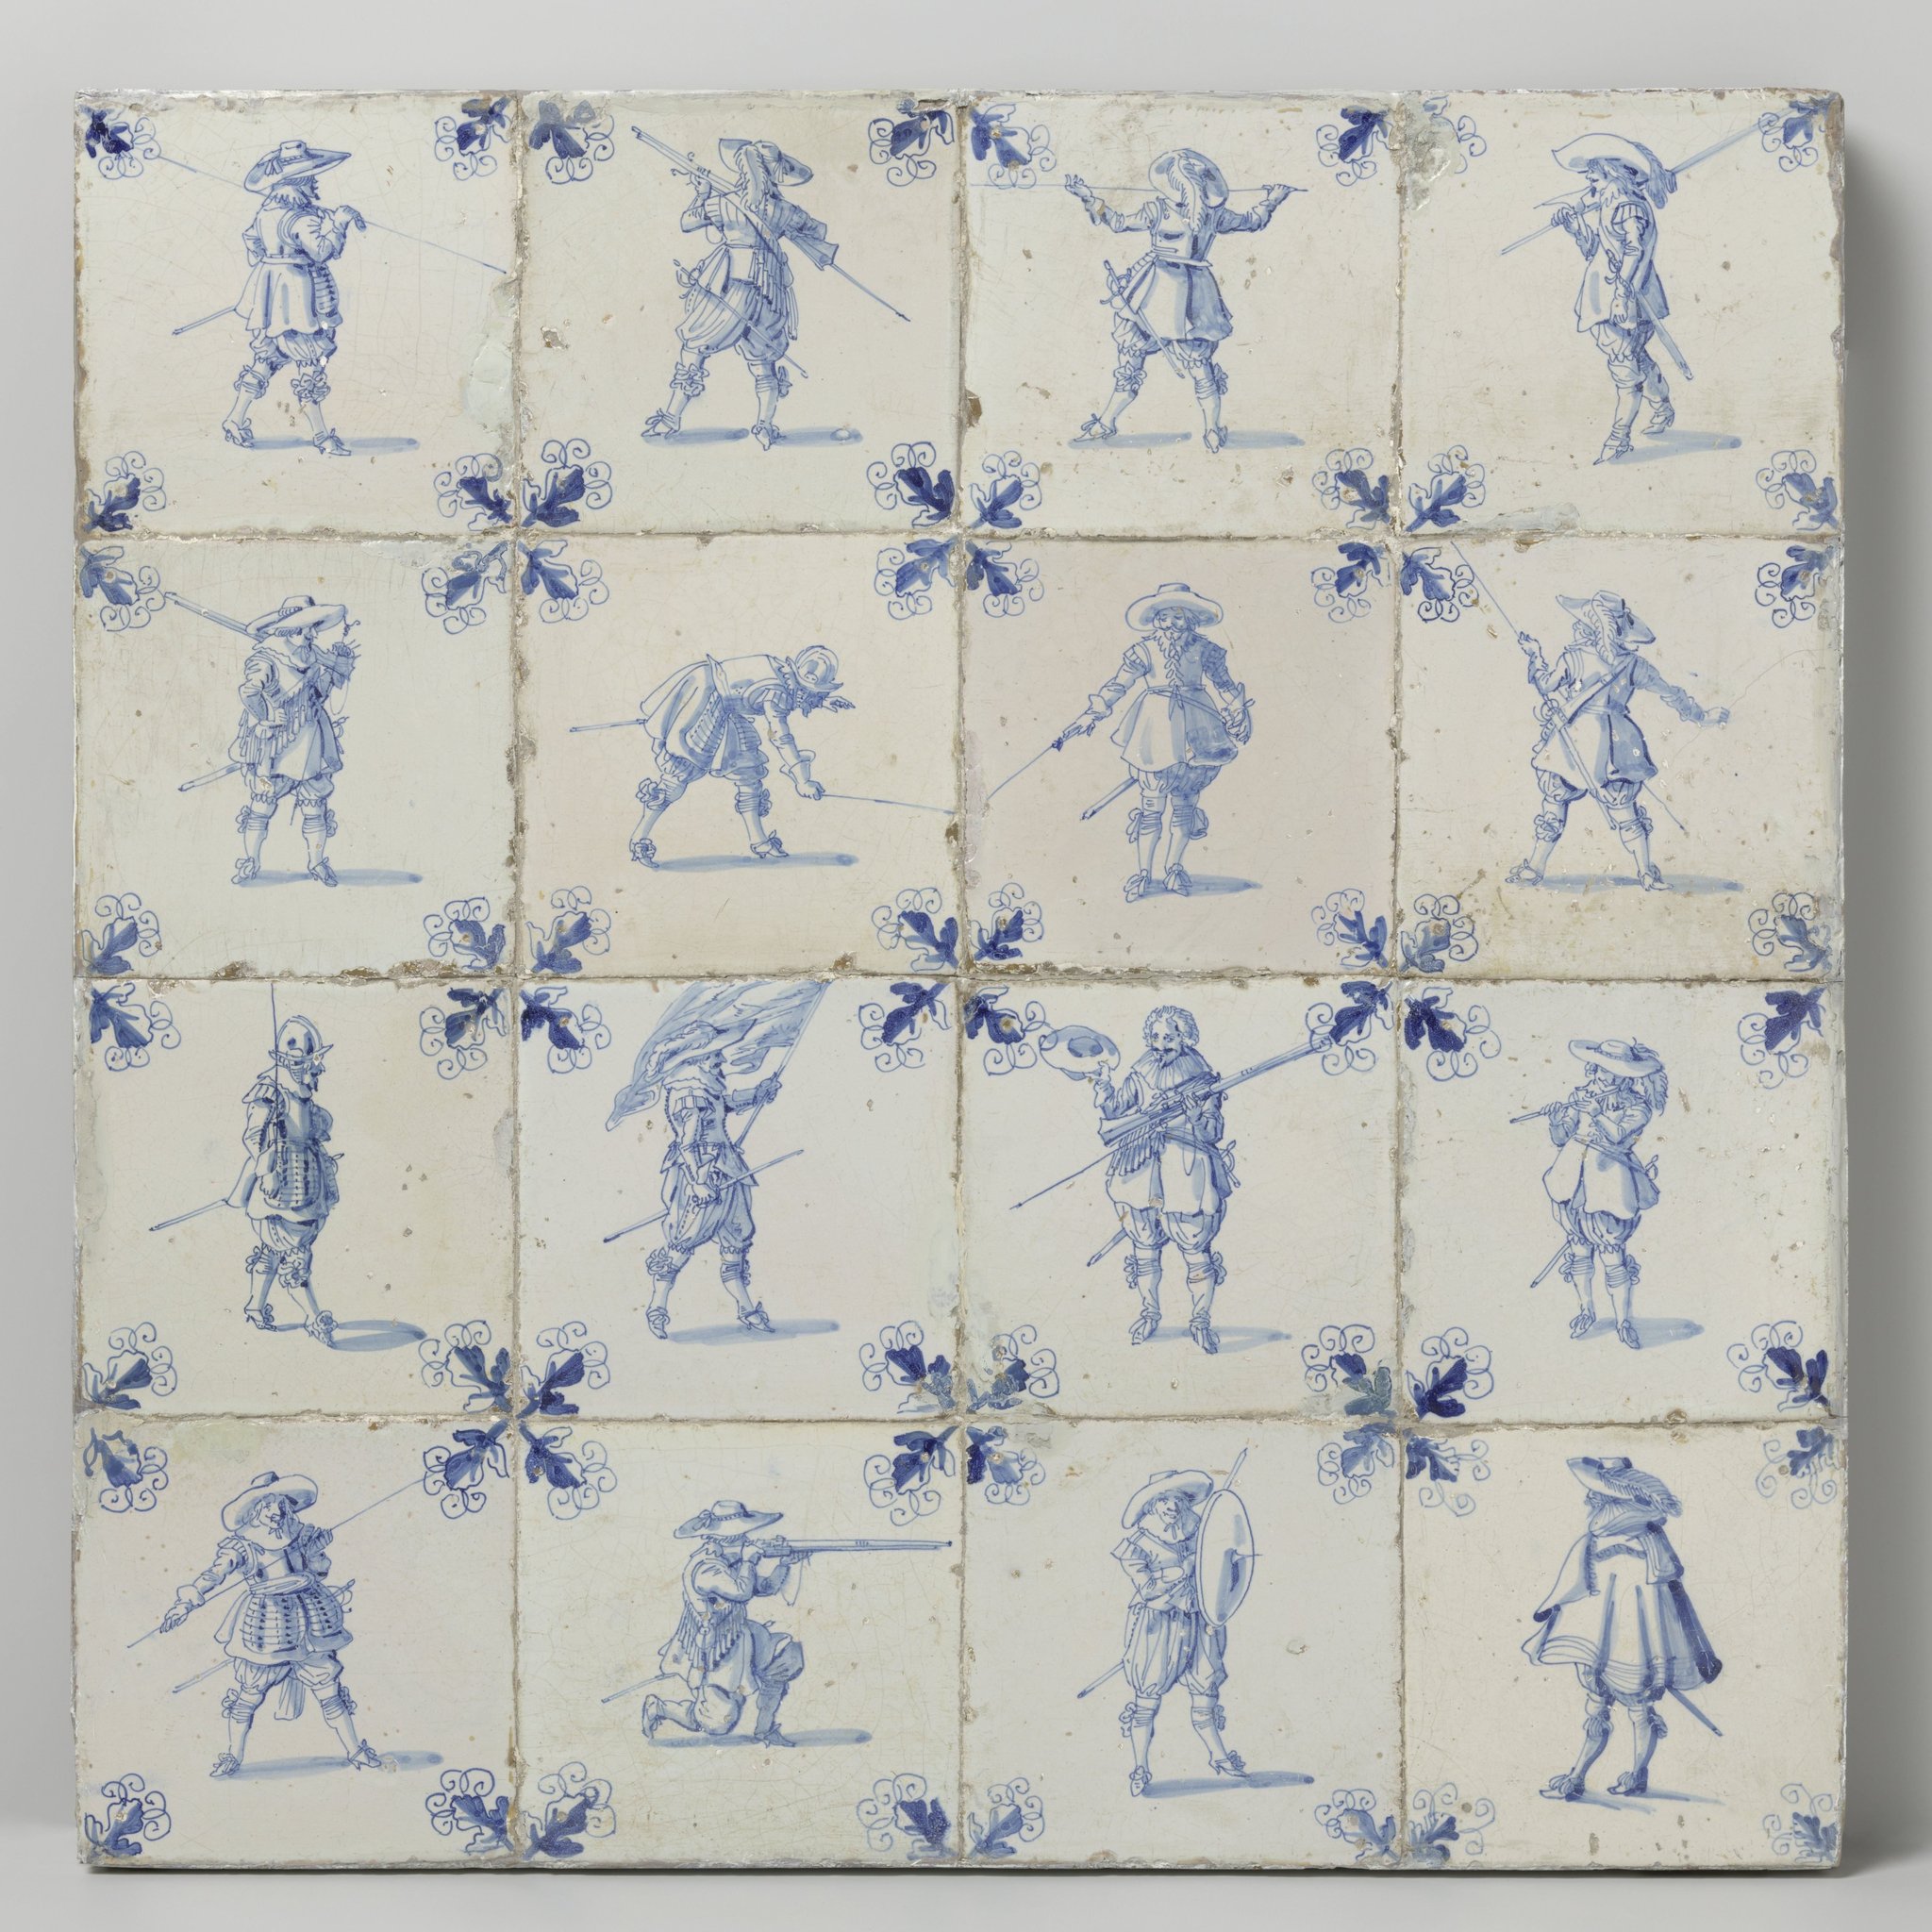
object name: tegelveld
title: Veld van zestien tegels met soldaten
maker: Anonymous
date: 1620-1650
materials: earthenware, glaze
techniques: maiolica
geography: netherlands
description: Veld van zestien tegels (4 x 4) elk met een blauw geschilderde soldaat met in de hoeken, een wingerd.